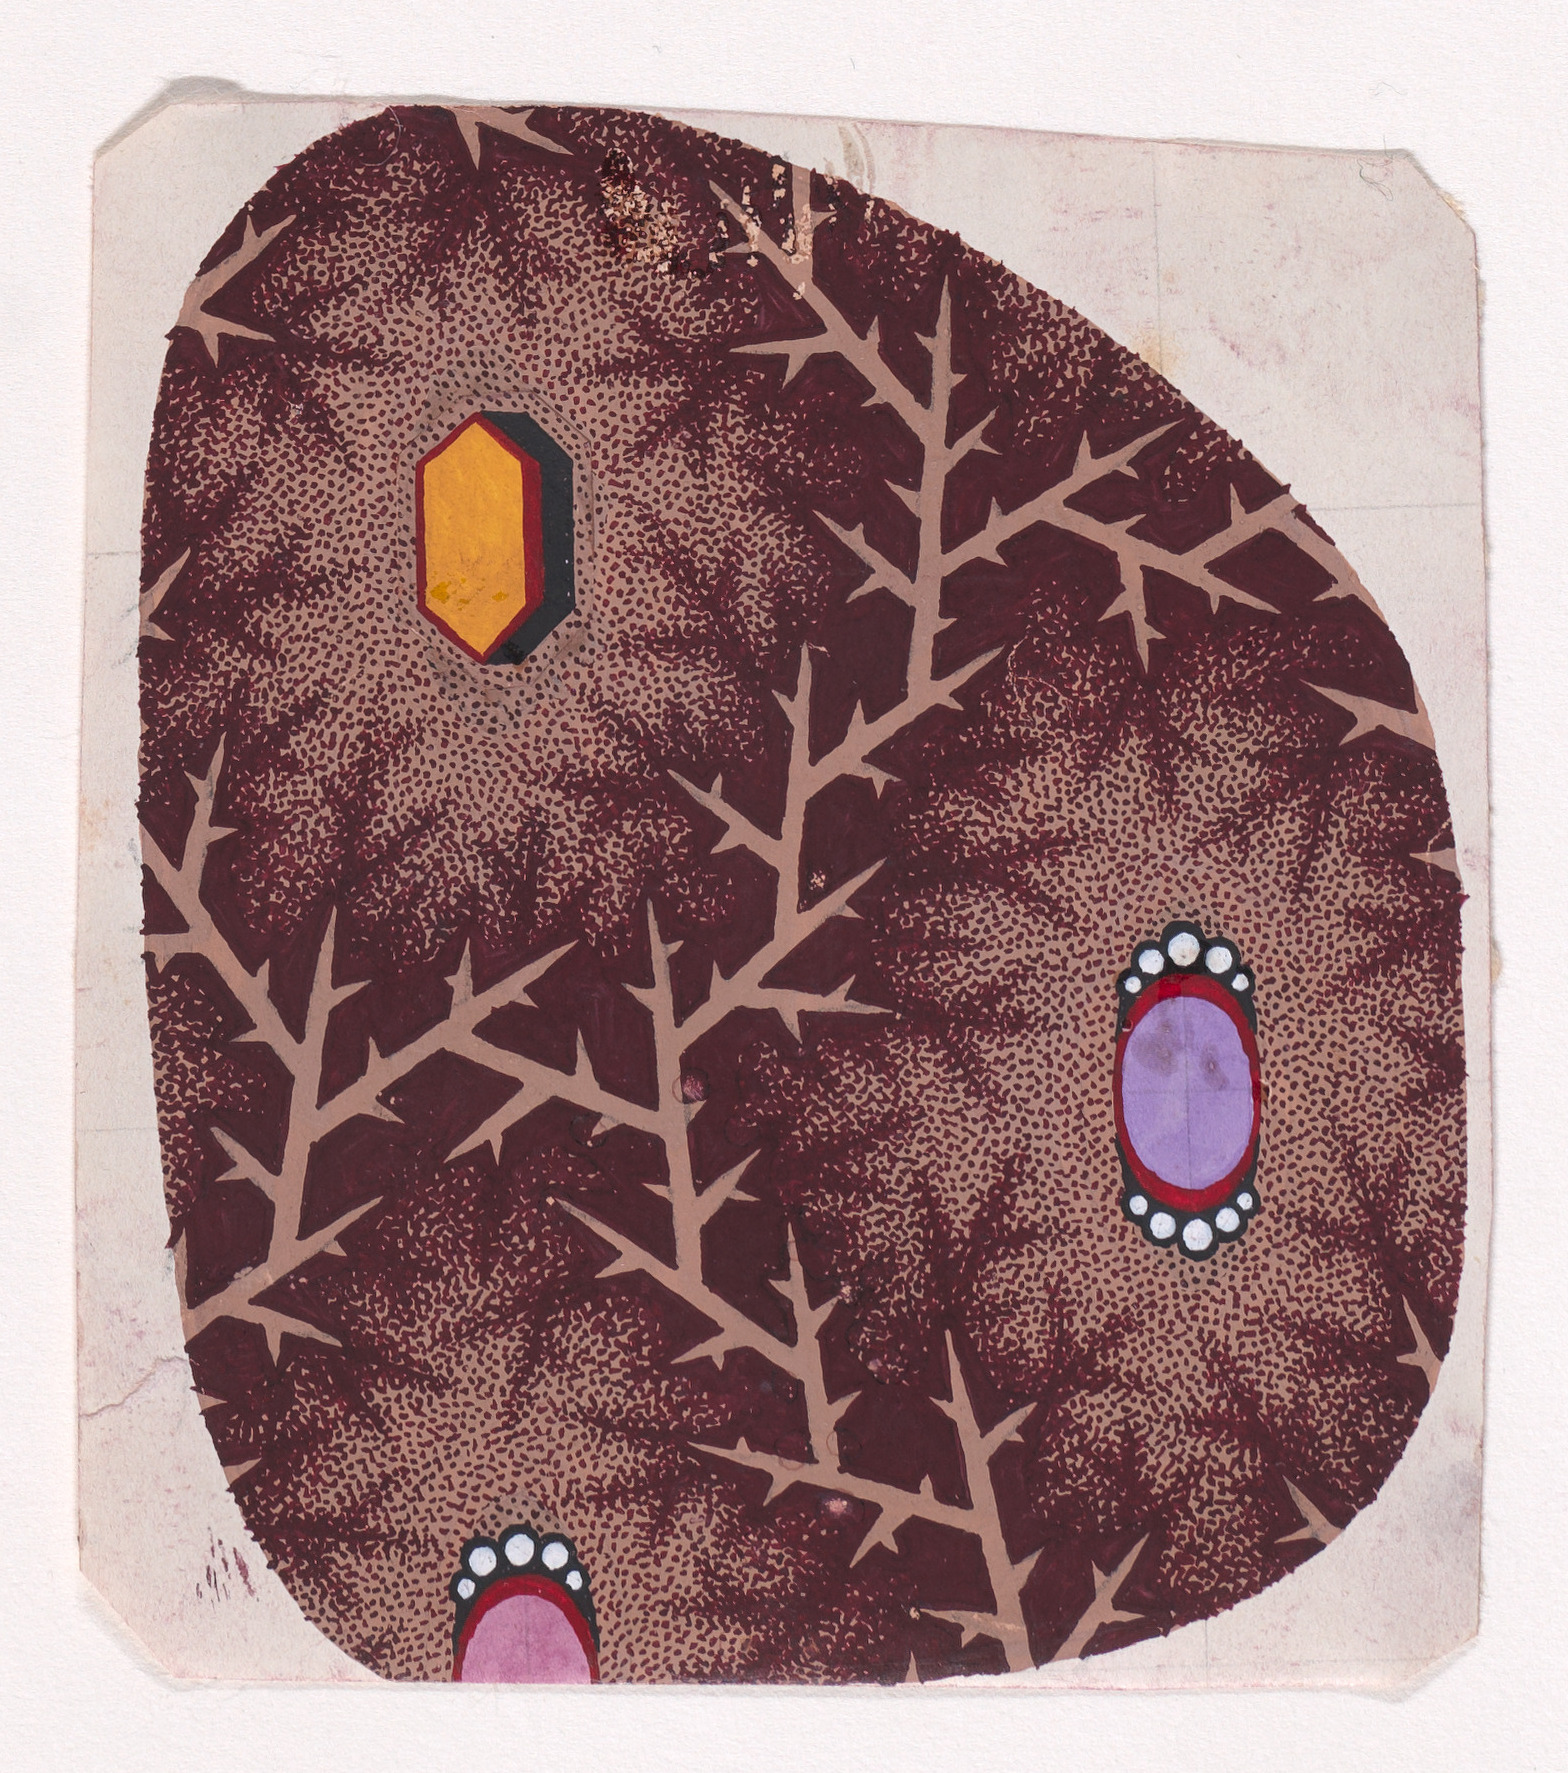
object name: drawing ornament architecture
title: Textile Design with Alternating Rows of Hexagons and Ovals Flanked by Pearls Framed by a Network of Stiff Branches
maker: anonymous, alsatian, 19th century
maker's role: artist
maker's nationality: alsatian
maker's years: 1800-1900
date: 1840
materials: gouache